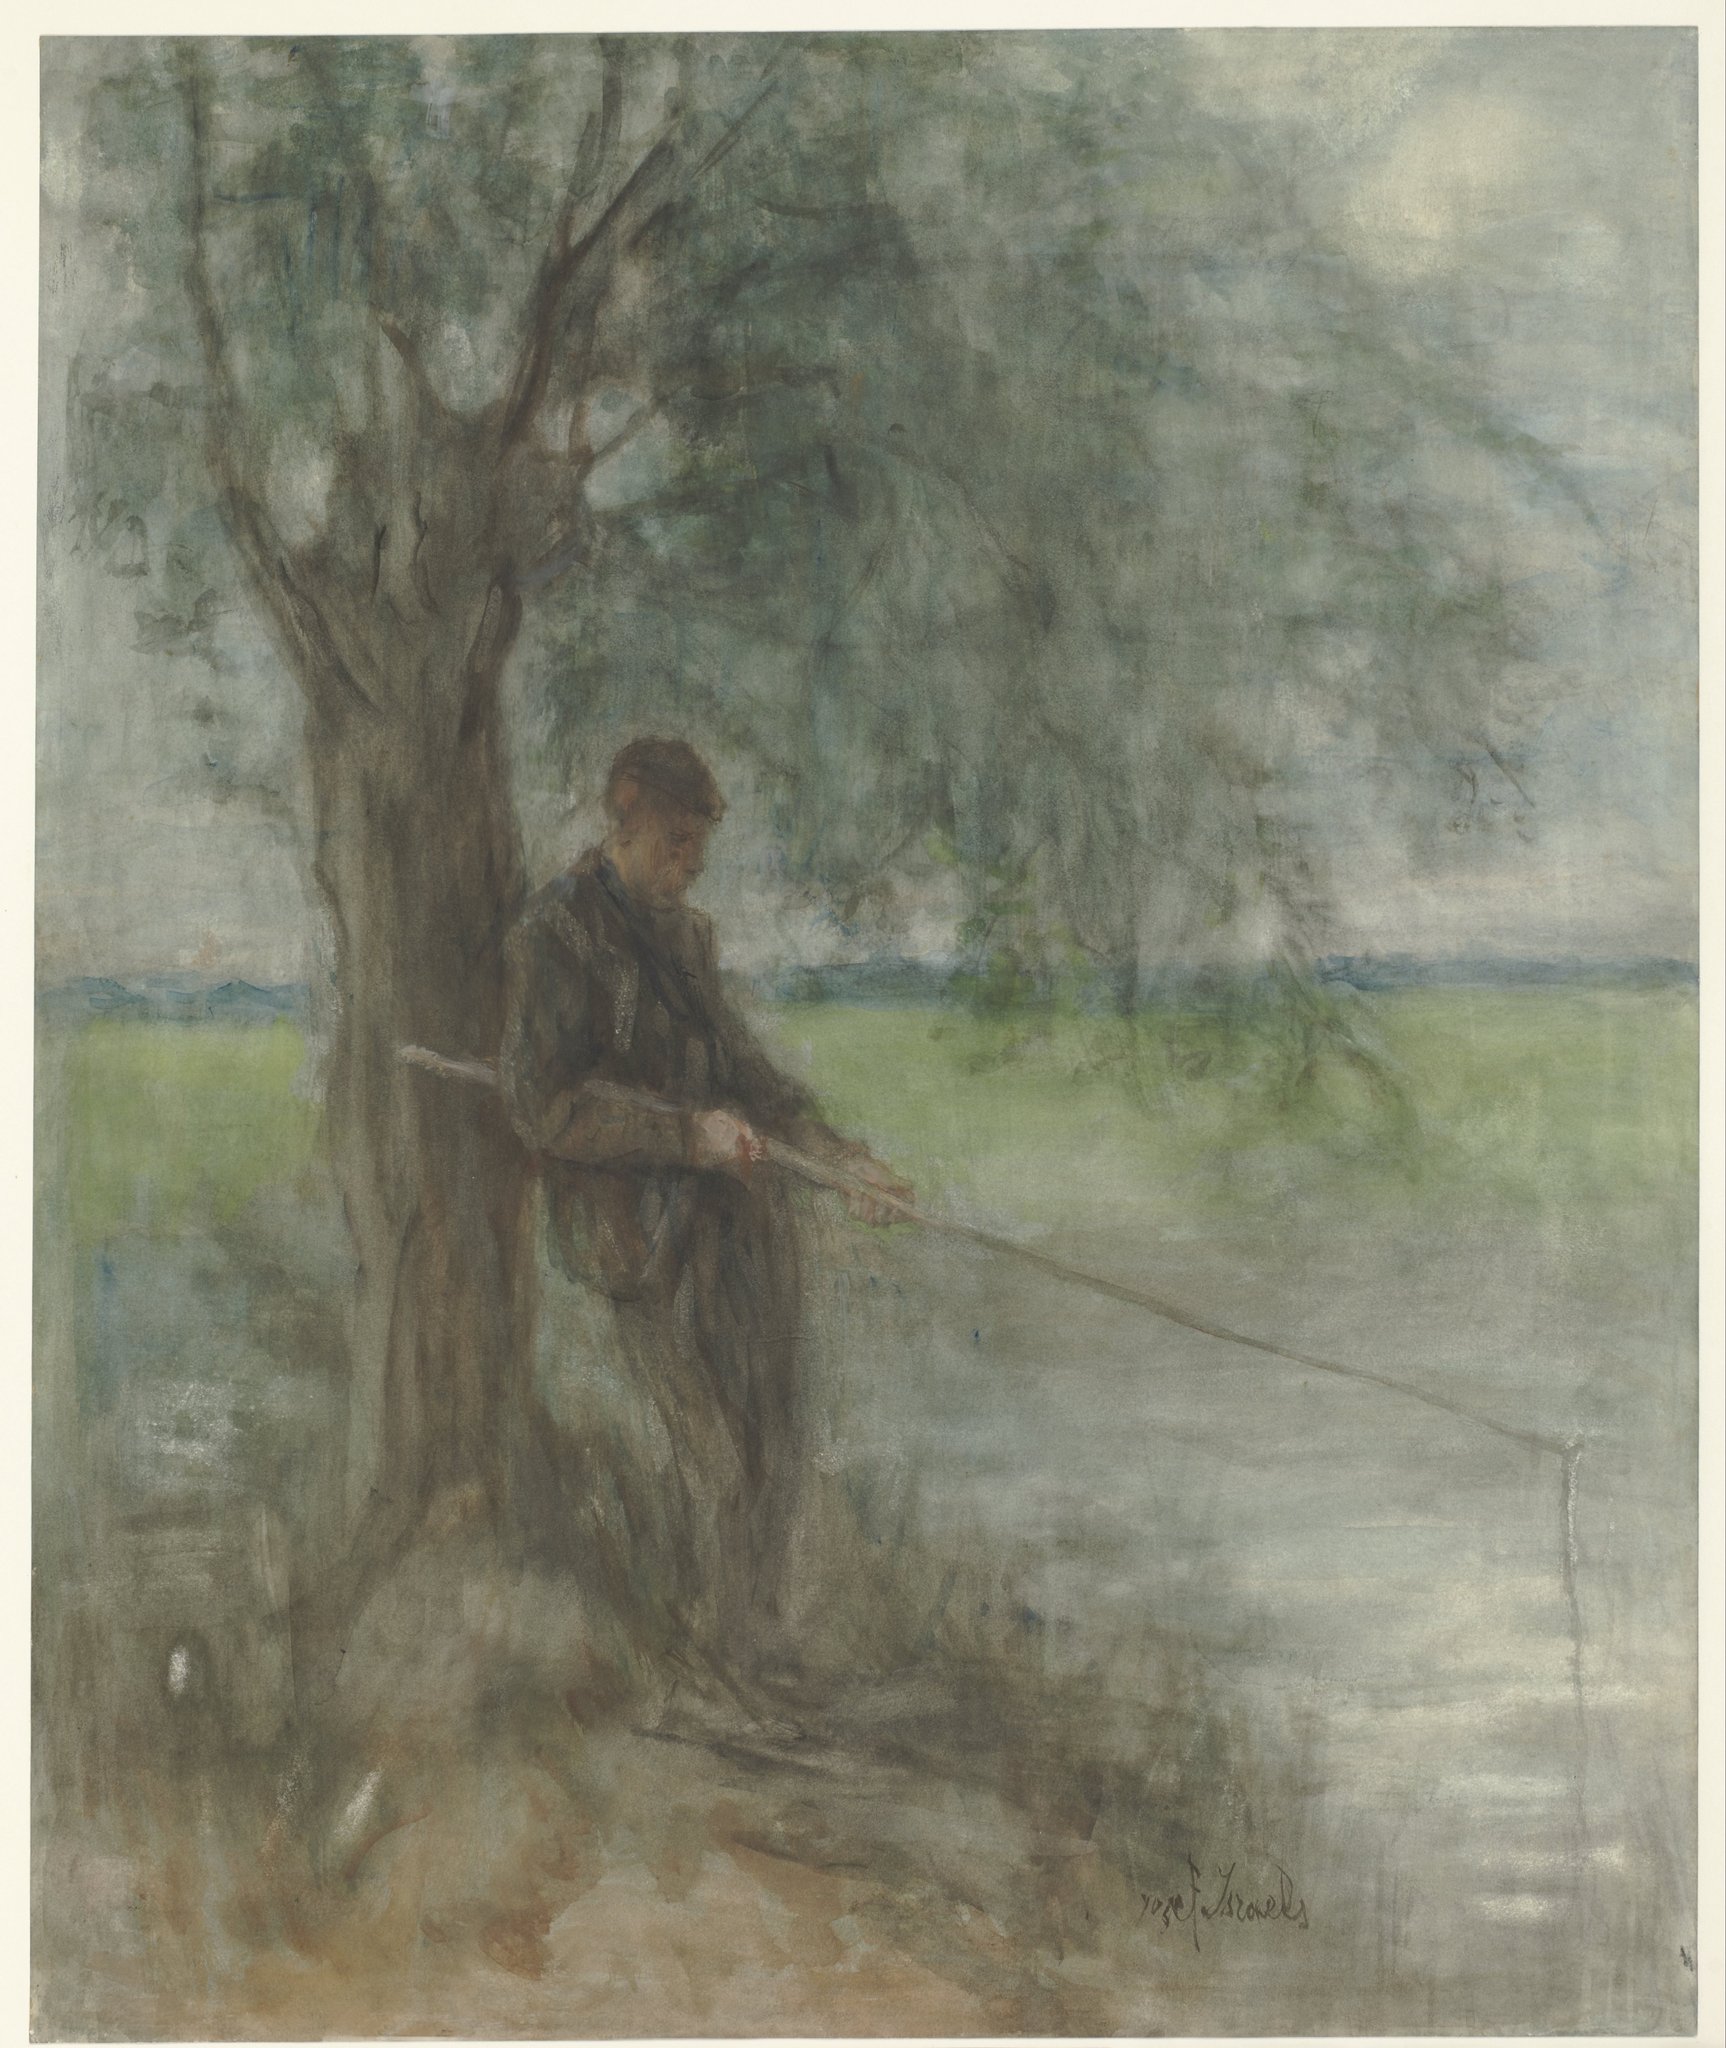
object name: drawing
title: Een hengelaar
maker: jozef israëls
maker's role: draughtsman, painter, print maker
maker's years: 1824-1911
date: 1834-1911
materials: paper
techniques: brush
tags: angling